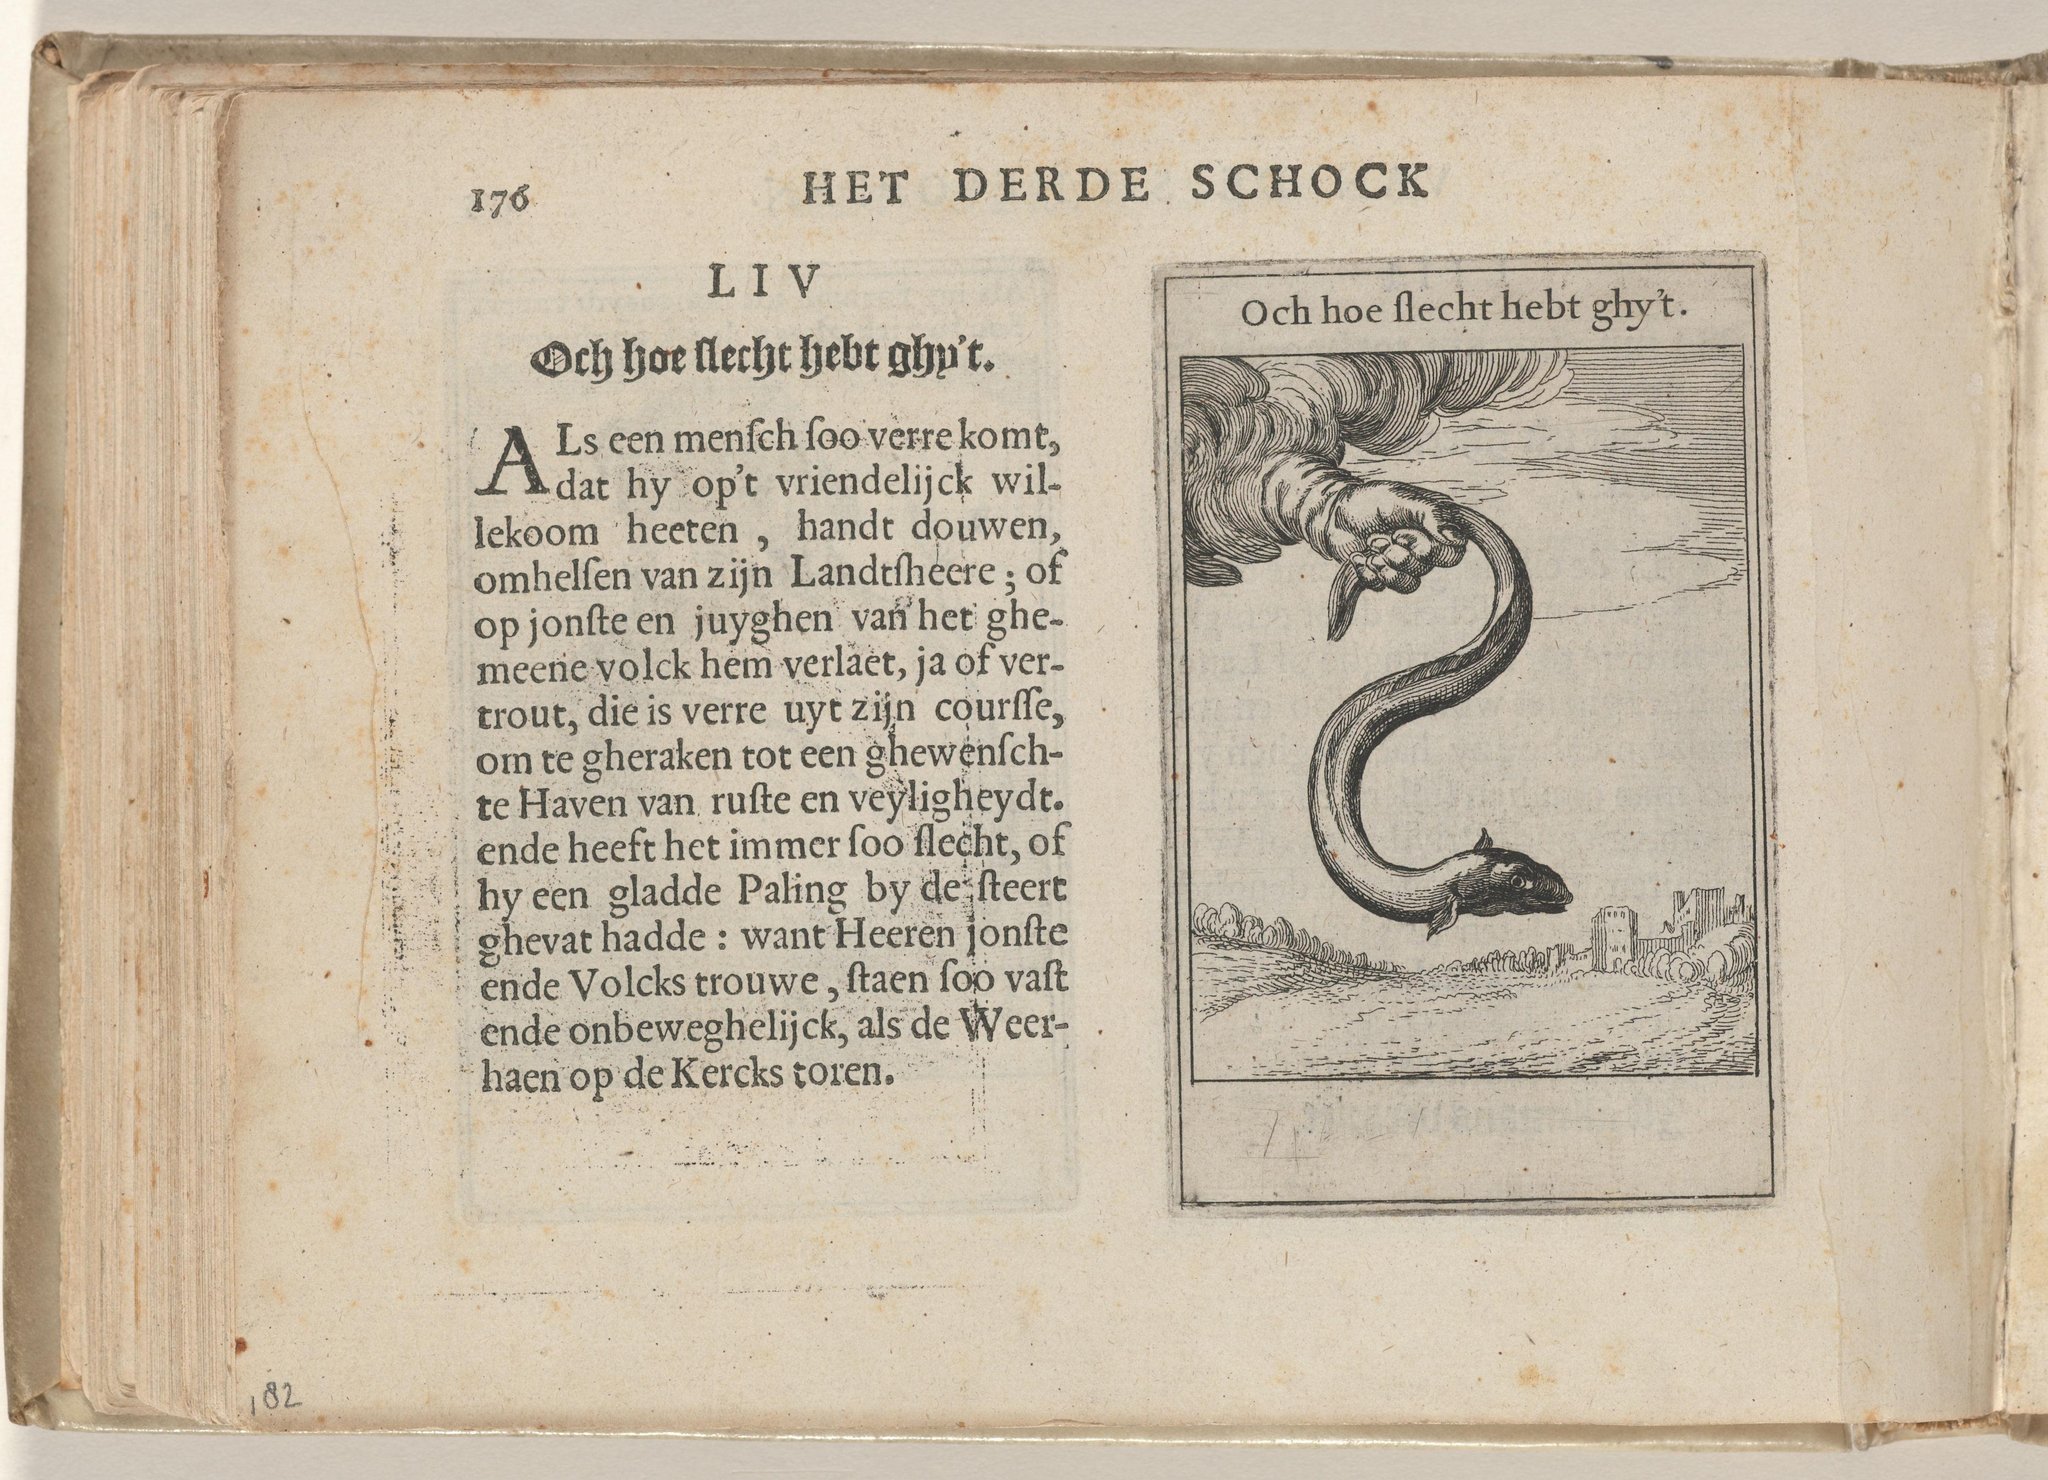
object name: print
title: LIV Och hoe slecht hebt ghy't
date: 1614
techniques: engraving, printing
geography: the hague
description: LIV Och hoe slecht hebt ghy't. Derde schok. Onderdeel van 'Sinnepoppen', R. Visscher, 1614.